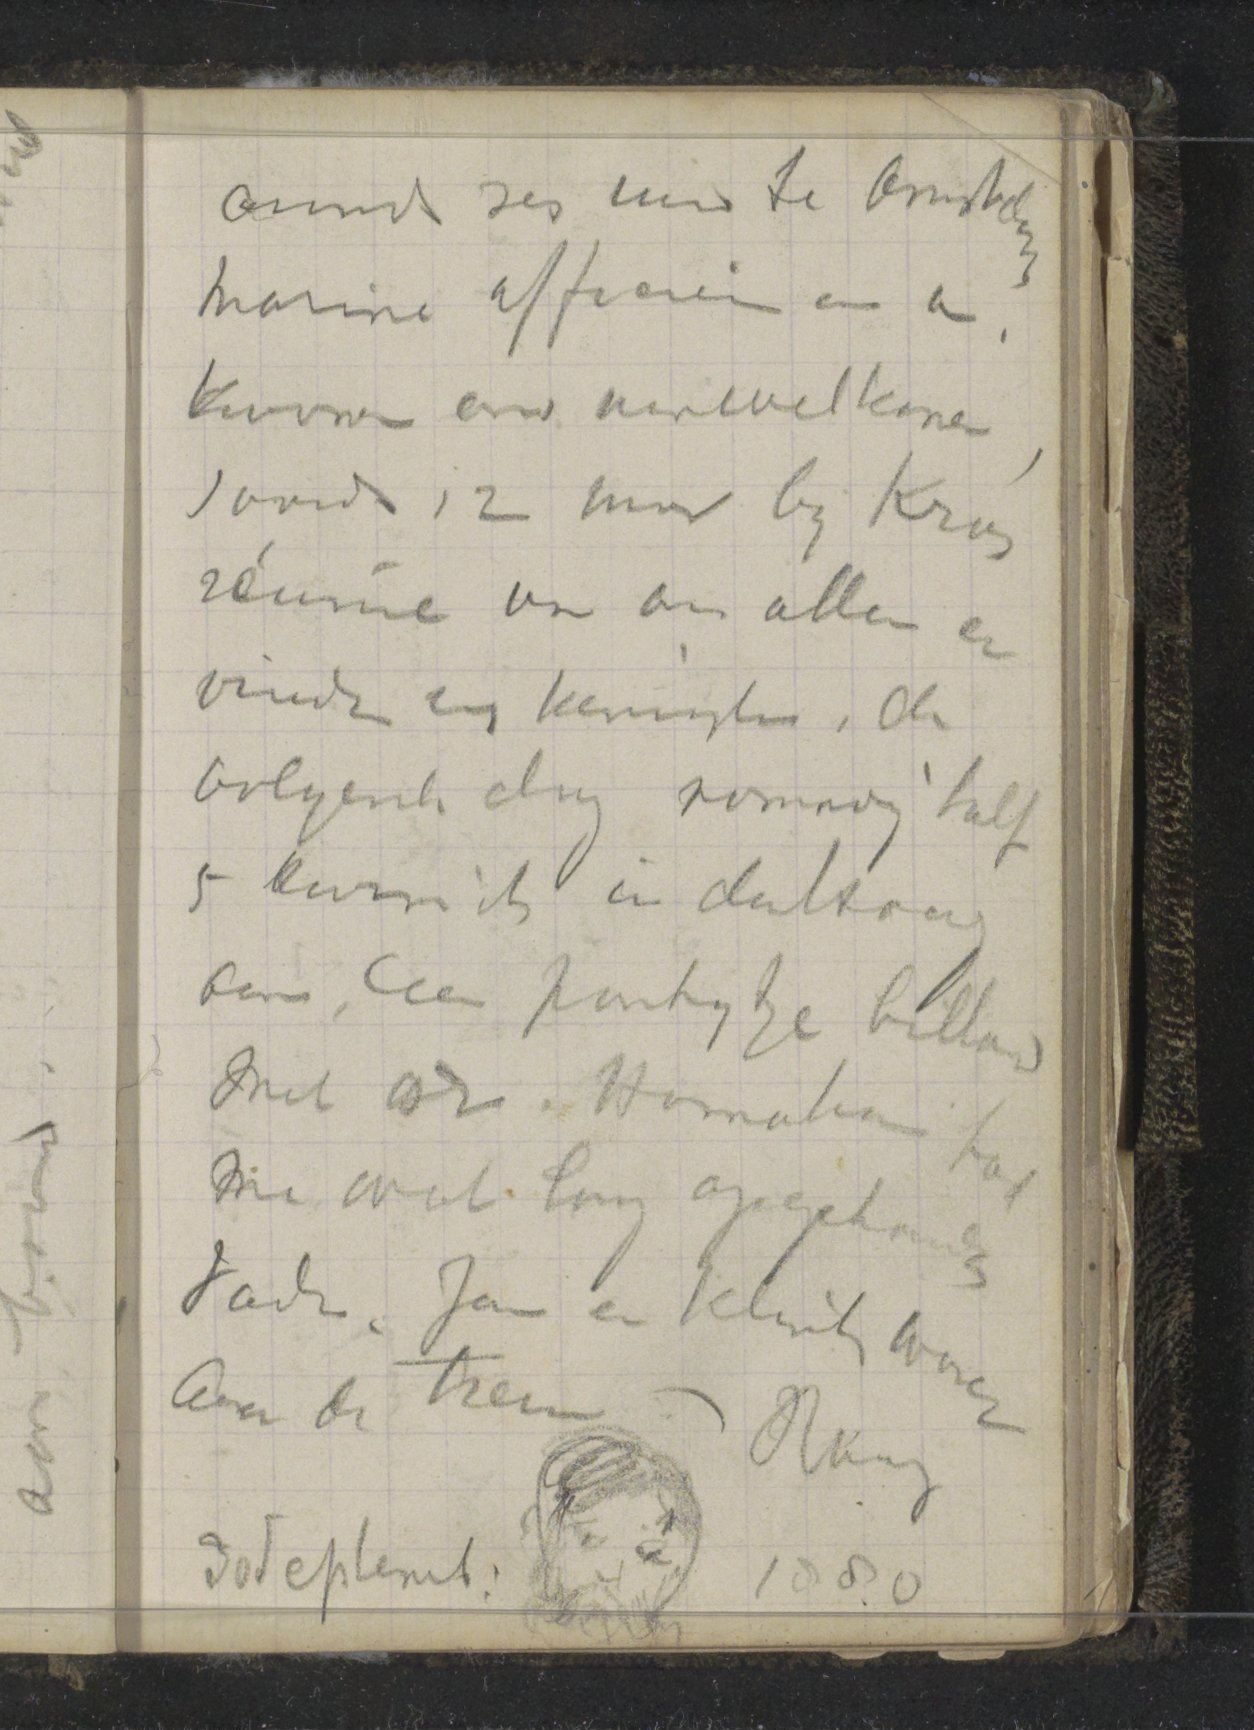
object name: sketchbook leaf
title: Reisverslag met een portret van een onbekende man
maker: louis apol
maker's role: draughtsman, painter, print maker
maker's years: 1850-1936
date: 1880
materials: pencil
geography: barentsz sea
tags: anonymous historical person portrayed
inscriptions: annotation: ‘[...]’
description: Mogelijk een bemanningslid van de Willem Barentsz. Blad 71 recto uit een schetsboek met 110 bladen betekend tijdens de expeditie naar Nova Zembla in 1880.